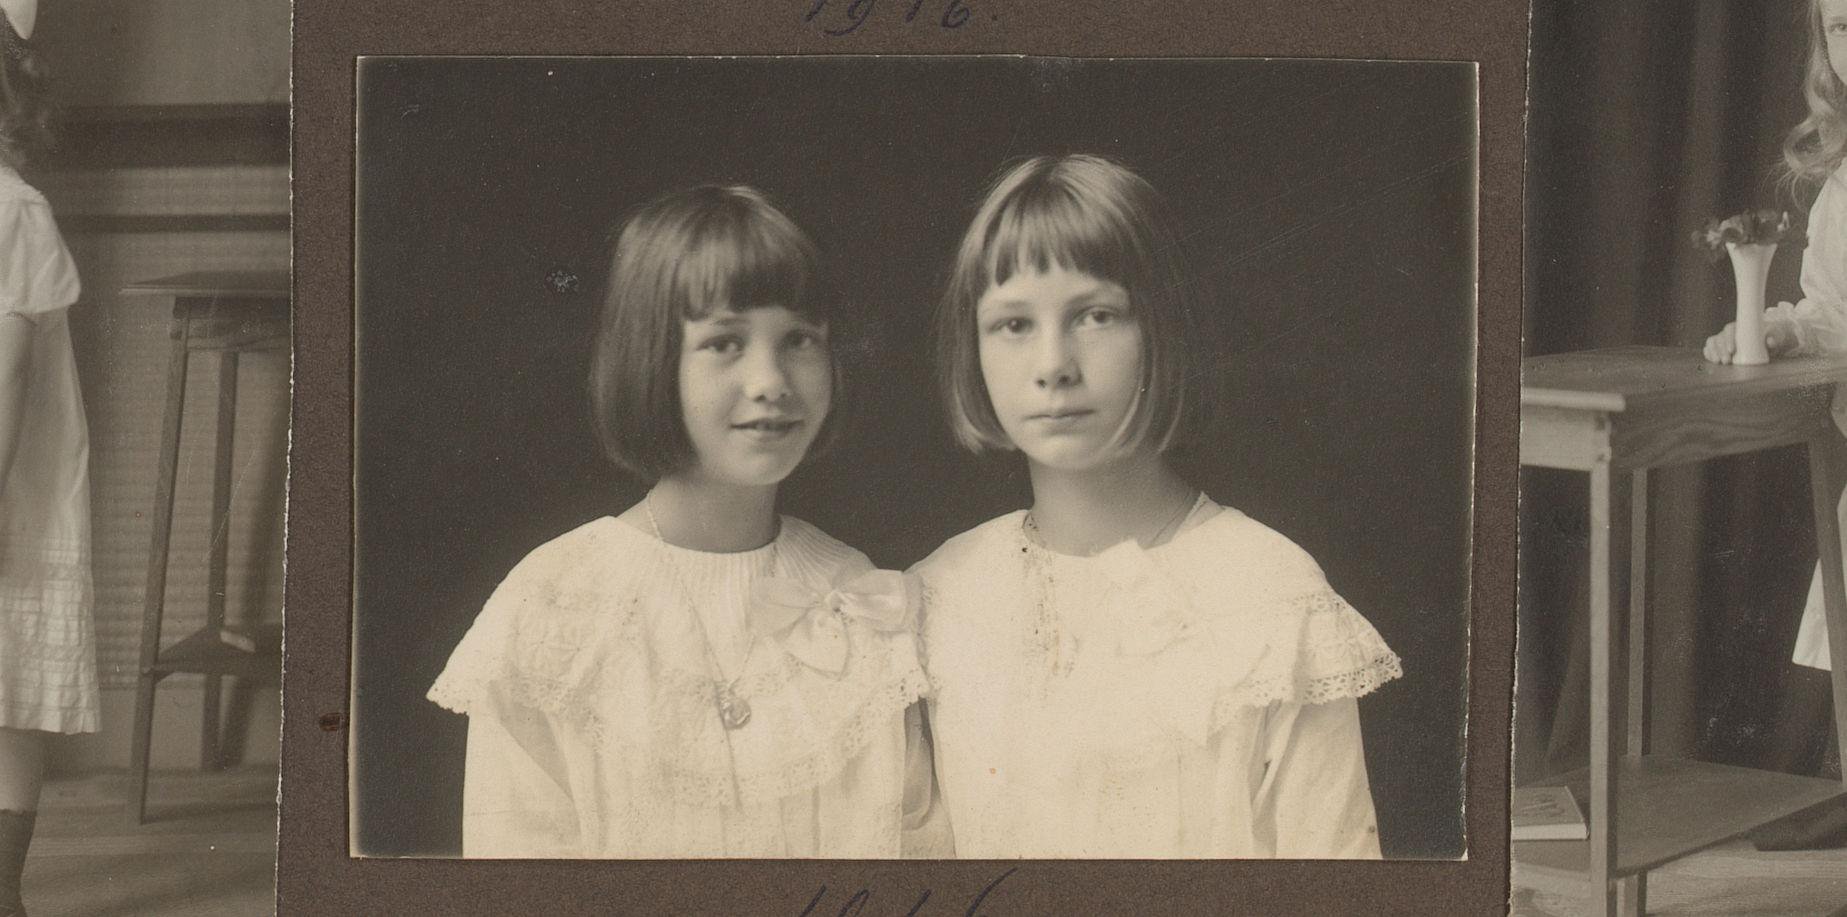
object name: photograph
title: Portret van Thea en Joanna Diepenbrock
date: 1916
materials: paper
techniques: gelatin silver print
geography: netherlands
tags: amsterdam, historical persons - bb - woman, bow (ornamental part of clothing), lace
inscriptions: date: ‘1916.’